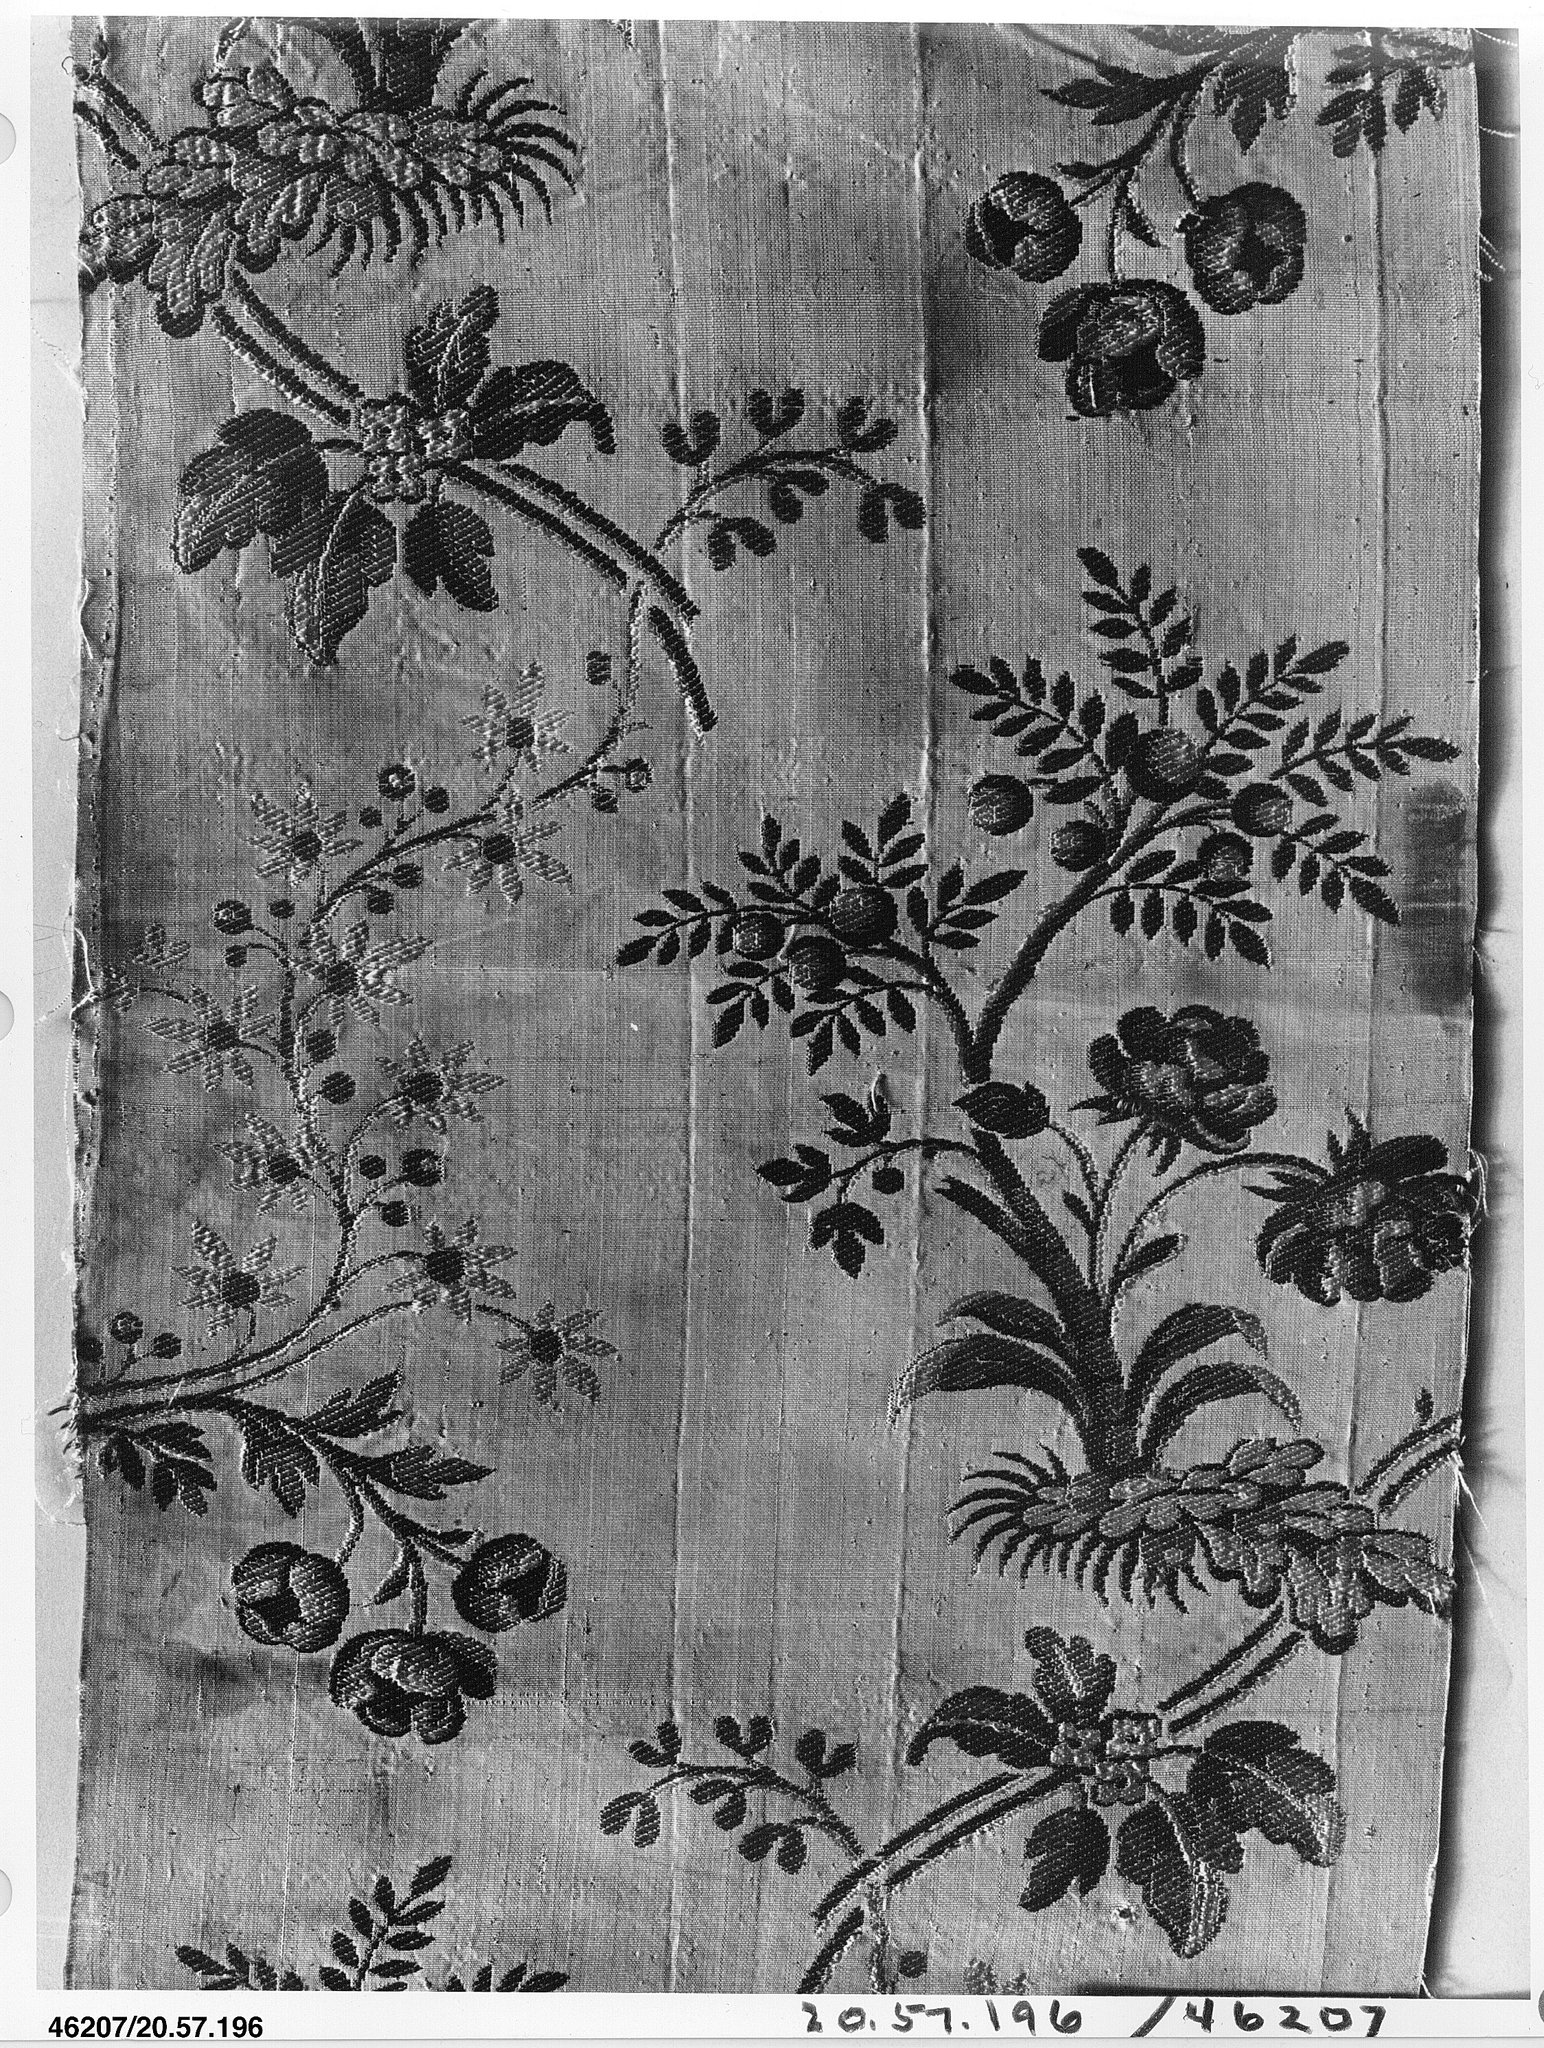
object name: piece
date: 1750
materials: silk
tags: flowers,leaves